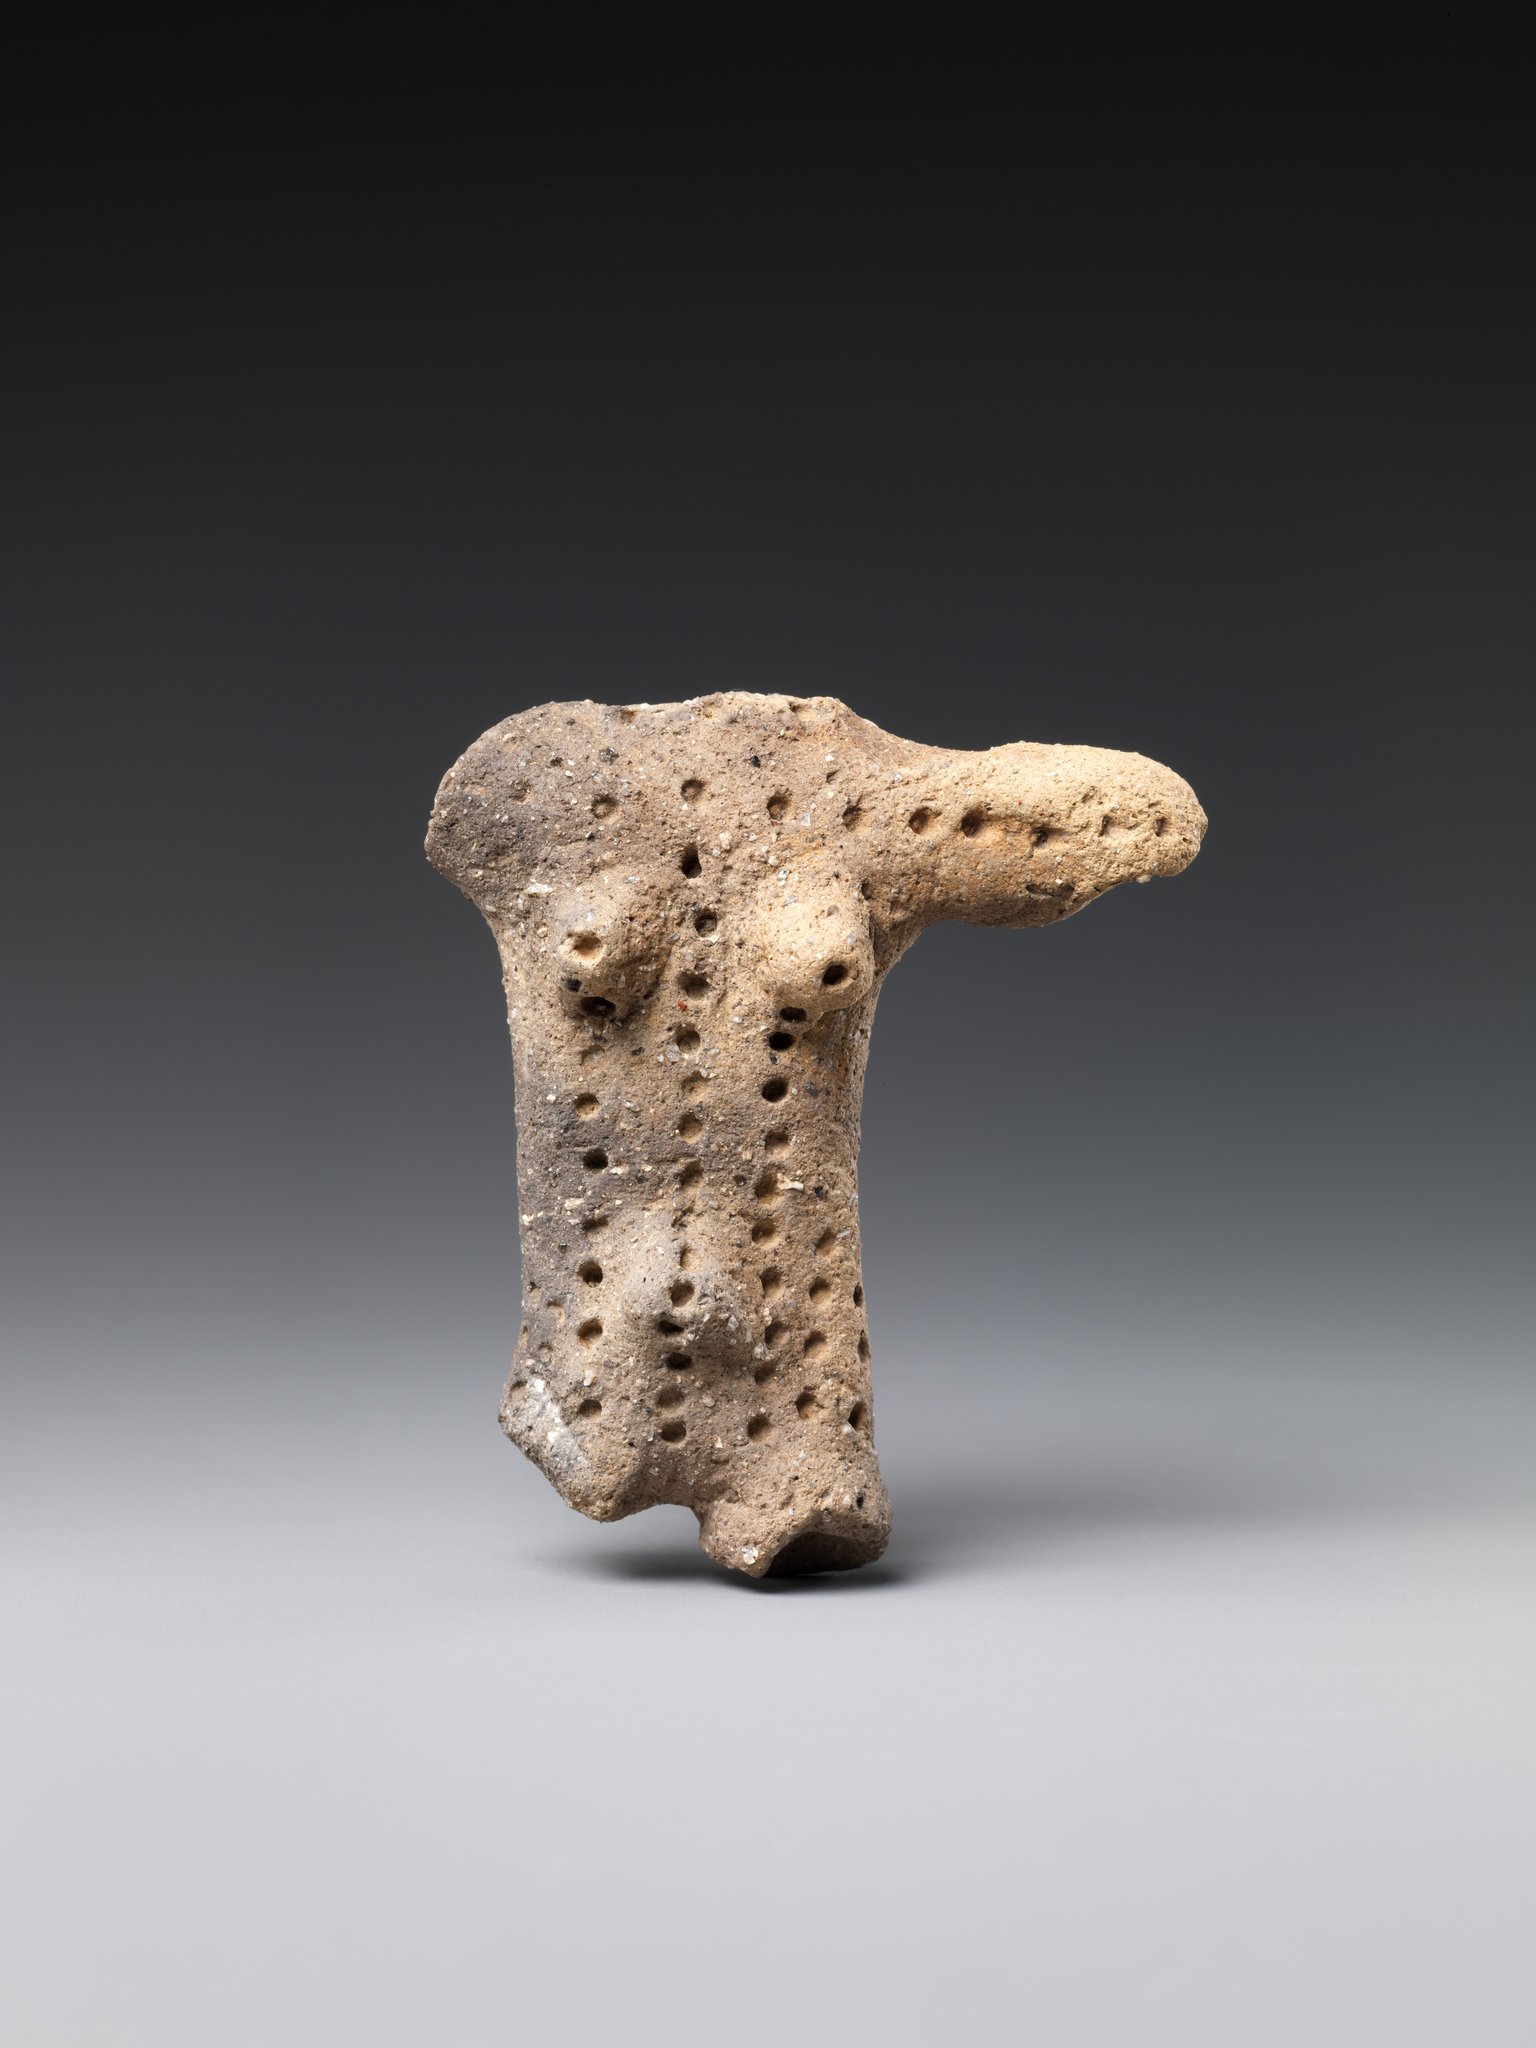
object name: figurine torso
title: Torso of a Figurine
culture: japanese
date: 3000-2000 BCE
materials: earthenware